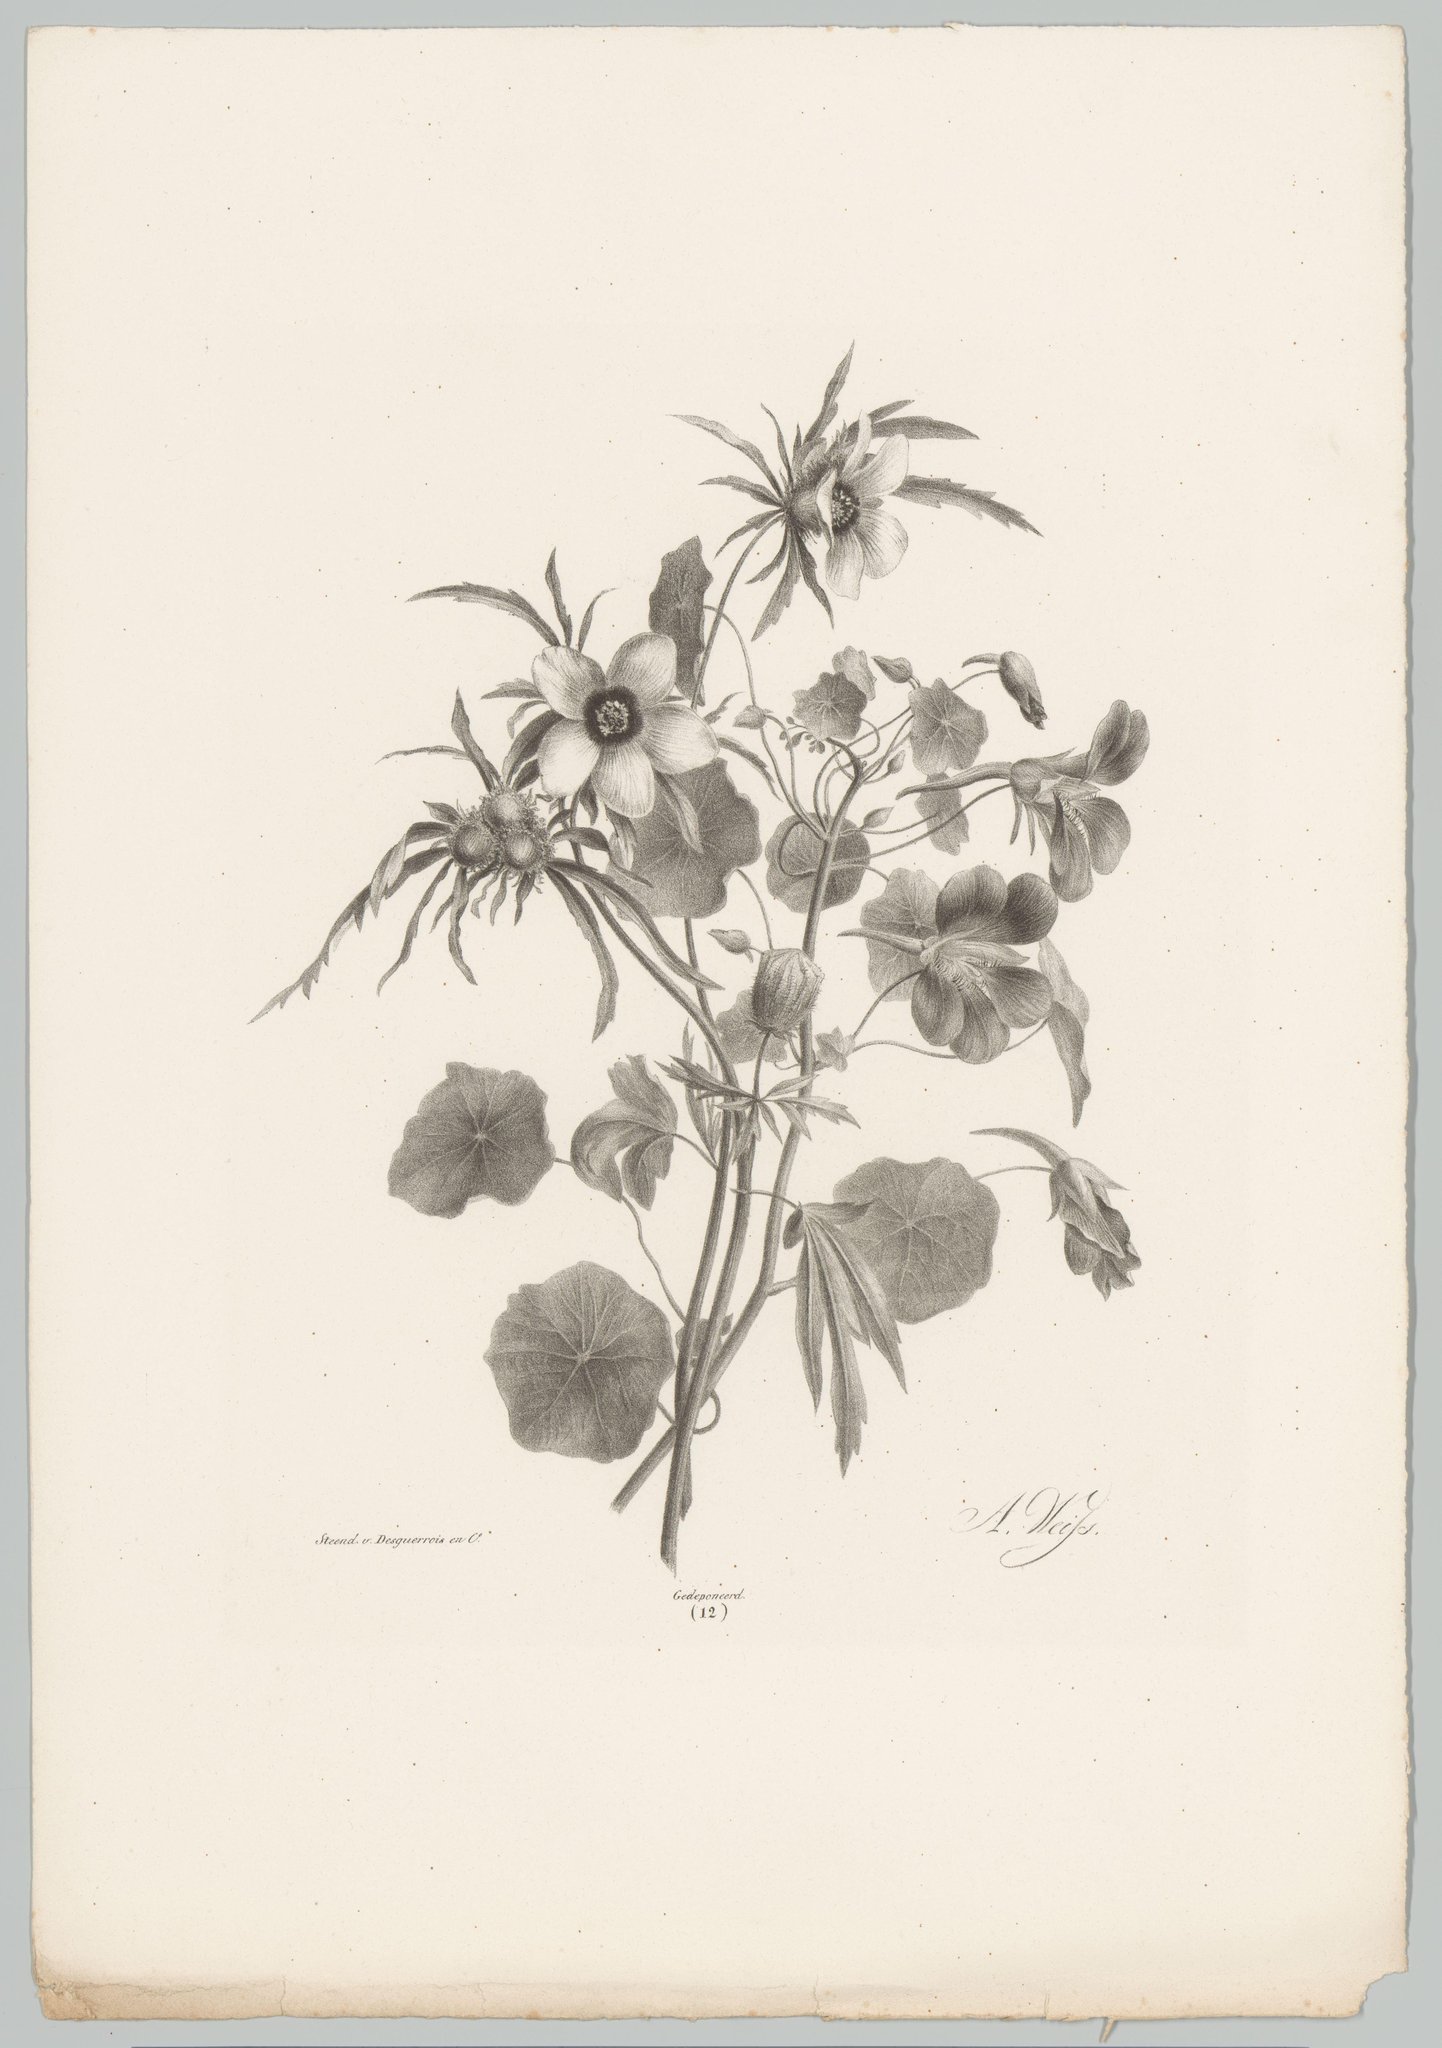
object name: print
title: Diverse bloemen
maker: anton weiss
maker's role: draughtsman, print maker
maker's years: 1801-1851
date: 1836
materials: paper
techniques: lithograph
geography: amsterdam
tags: flowers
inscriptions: collector's mark: Lugt 2228, : ‘Gedeponeerd.’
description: Onderdeel van een omslag met een serie van eenenveertig lithografieën van bloemen en fruit.